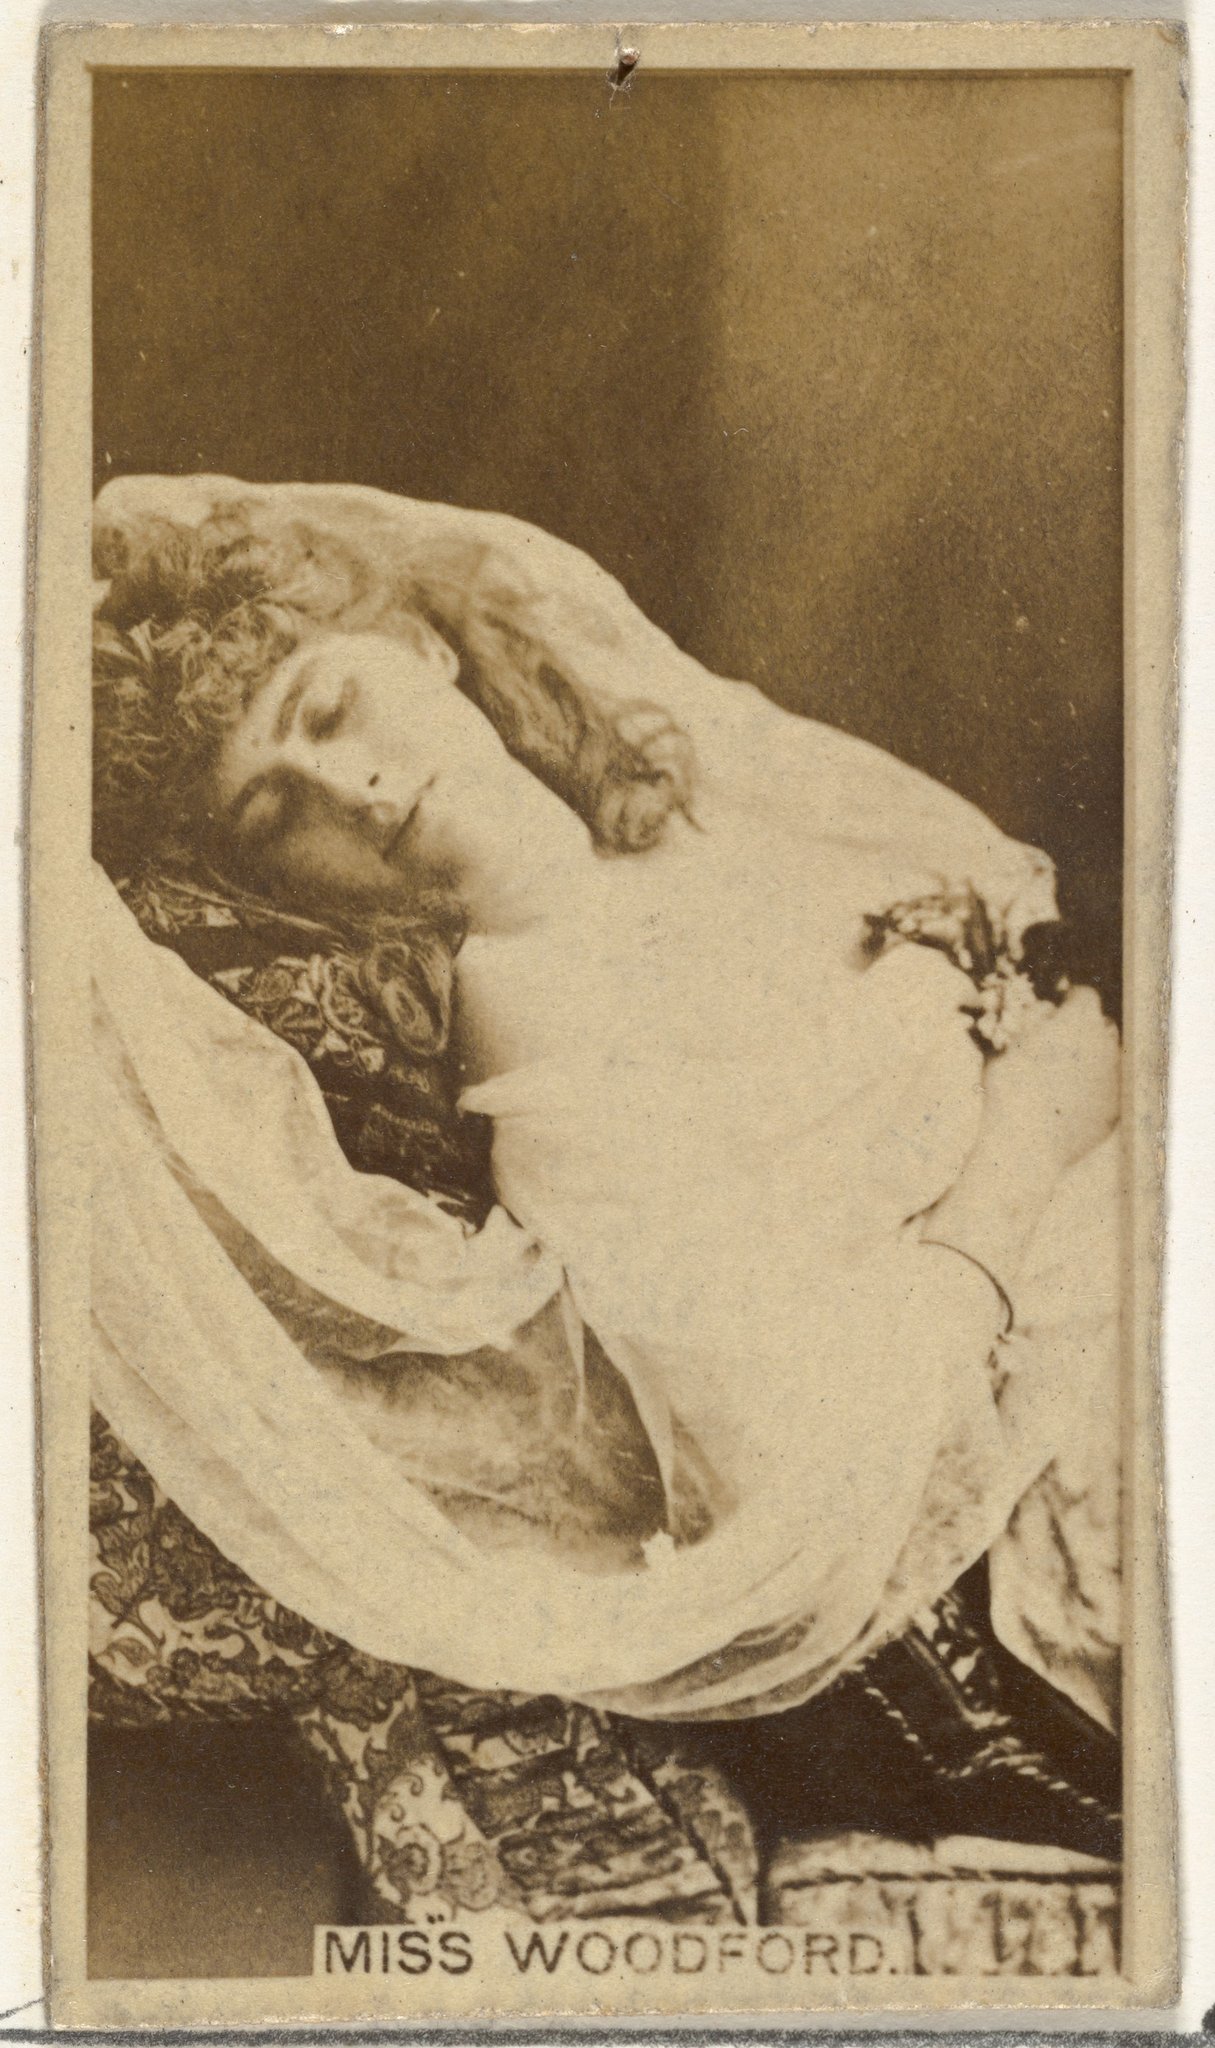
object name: photograph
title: Miss Woodford, from the Actors and Actresses series (N145-8) issued by Duke Sons & Co. to promote Duke Cigarettes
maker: w. duke, sons & co.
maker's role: publisher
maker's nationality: american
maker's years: 1870-1920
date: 1891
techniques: albumen silver print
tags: portraits,women,actresses